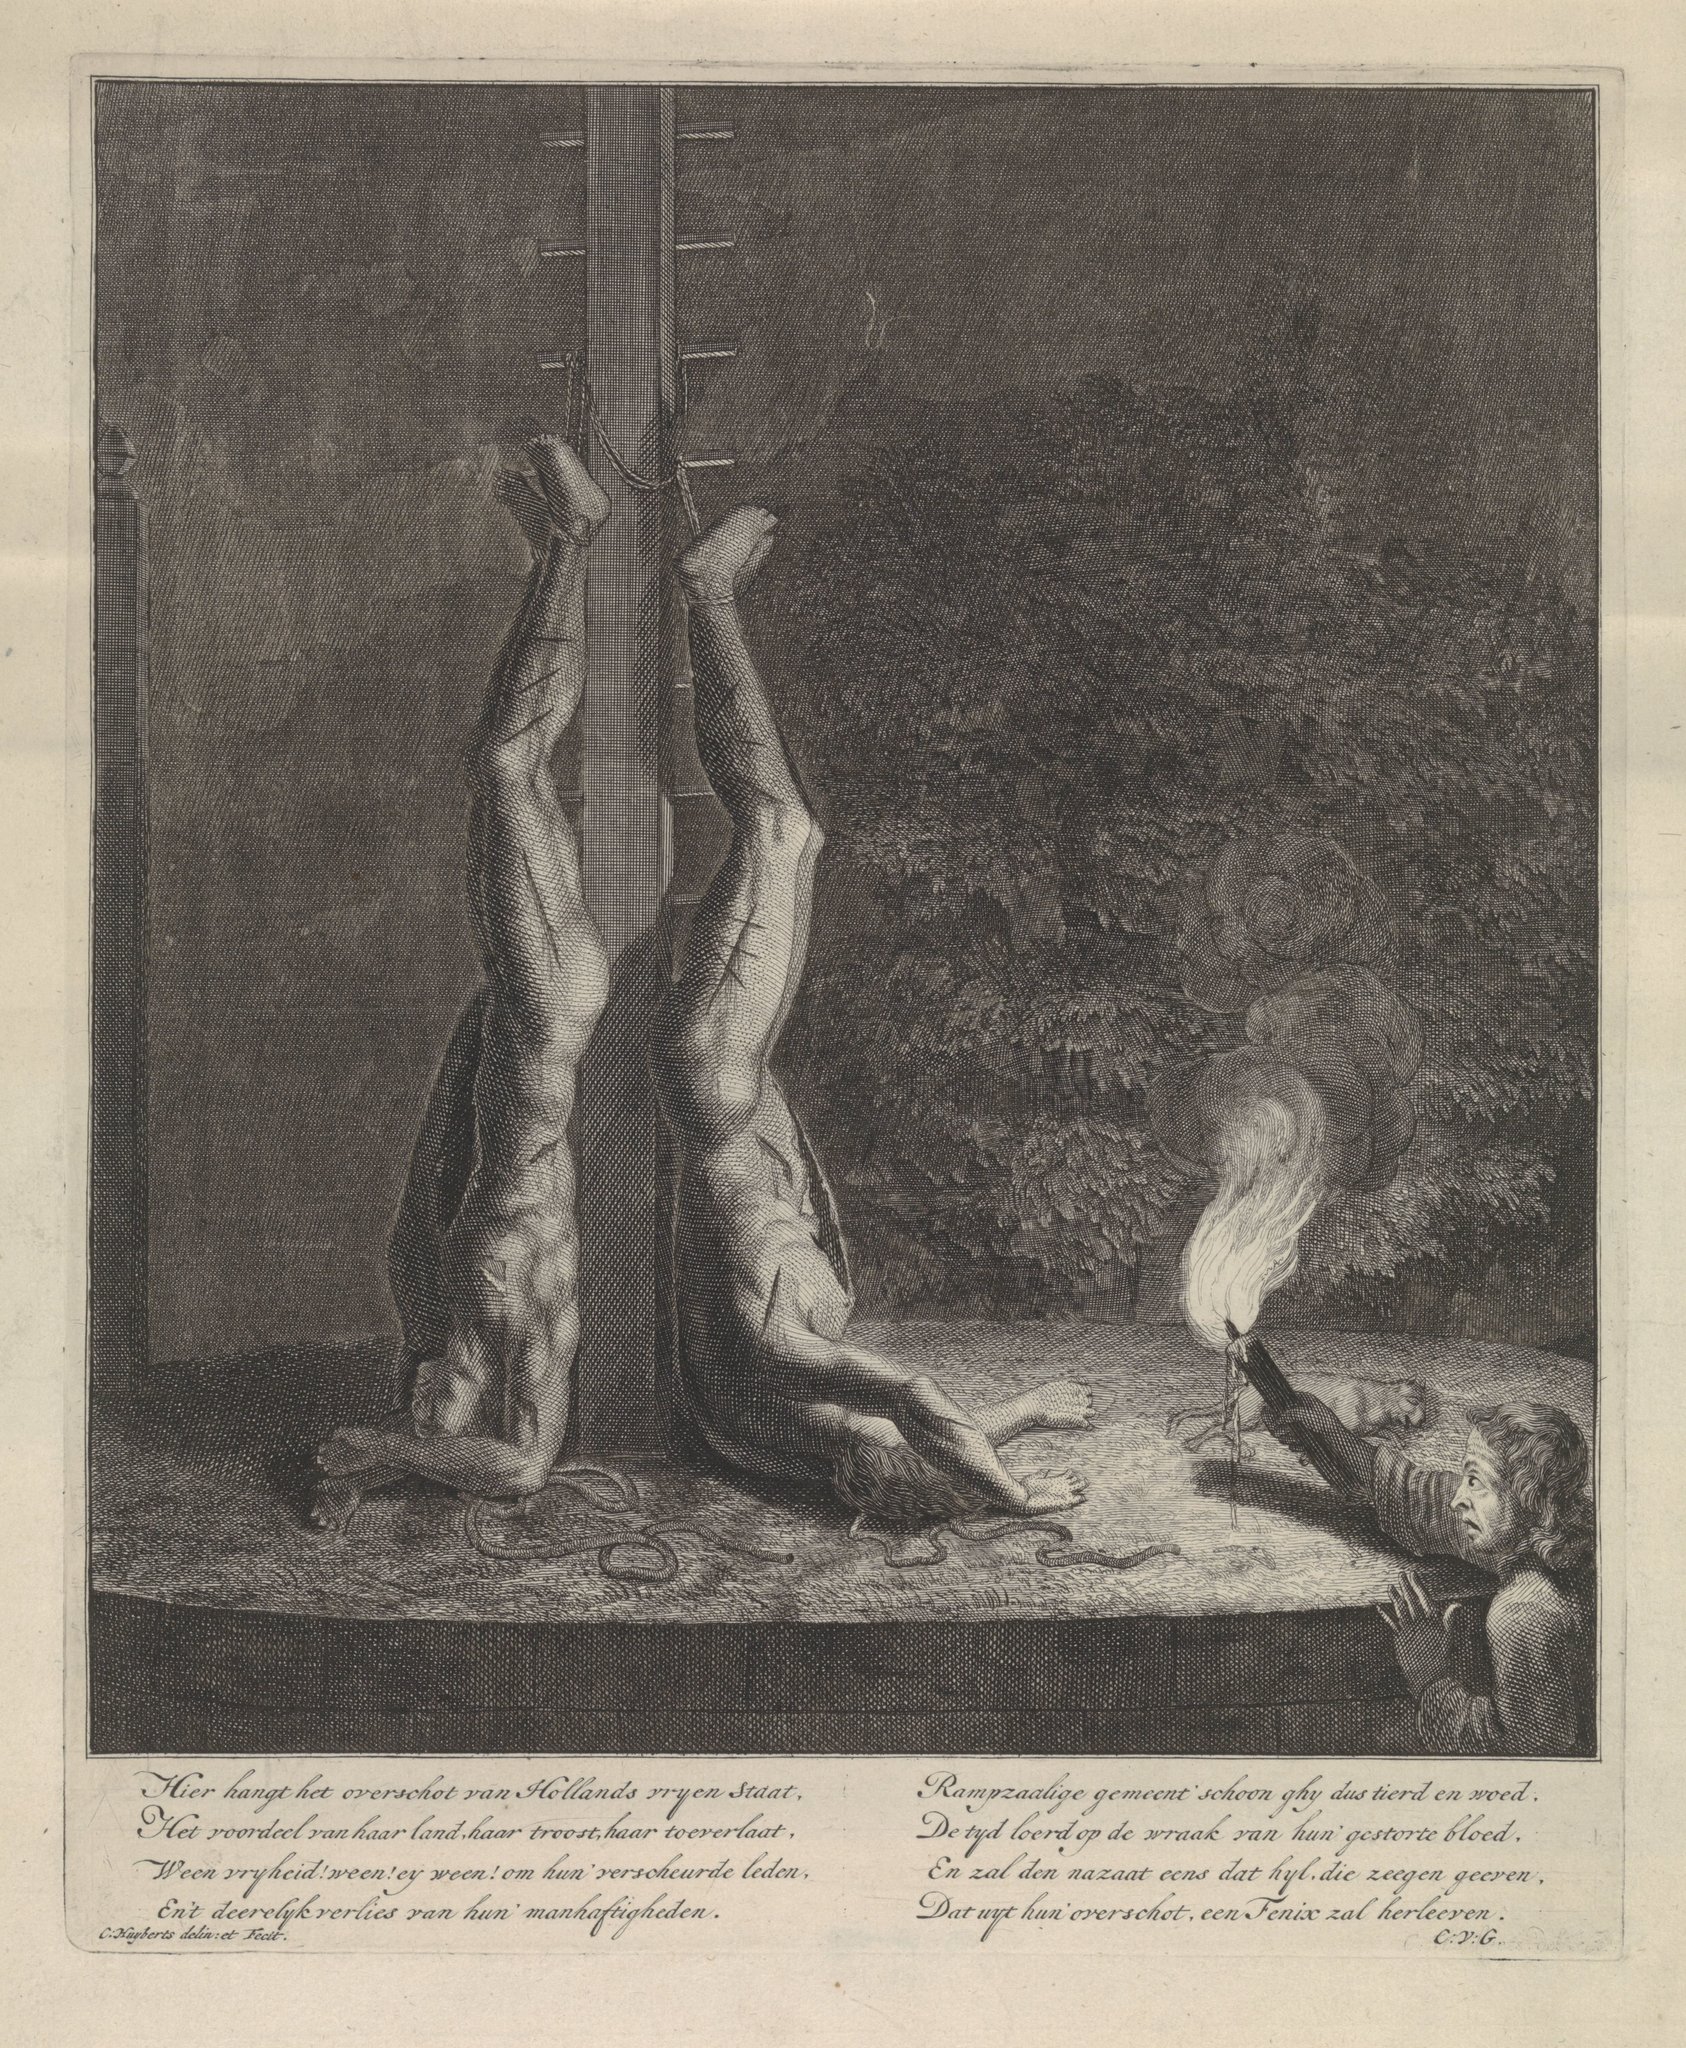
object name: print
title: Dood en verminking van de gebroeders de Witt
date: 1705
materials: paper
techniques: engraving, etching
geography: amsterdam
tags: dordrecht, the hague, cornelis de witt, politician, johan de witt, historical persons, historical events and situations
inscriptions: collector's mark: Lugt 2228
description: De verminkte lichamen van Johan en Cornelis de Witt hangend aan een paal. Rechts een man met een toorts, die de lijken gadeslaat. Onder een achtregelig vers in het Nederlands.